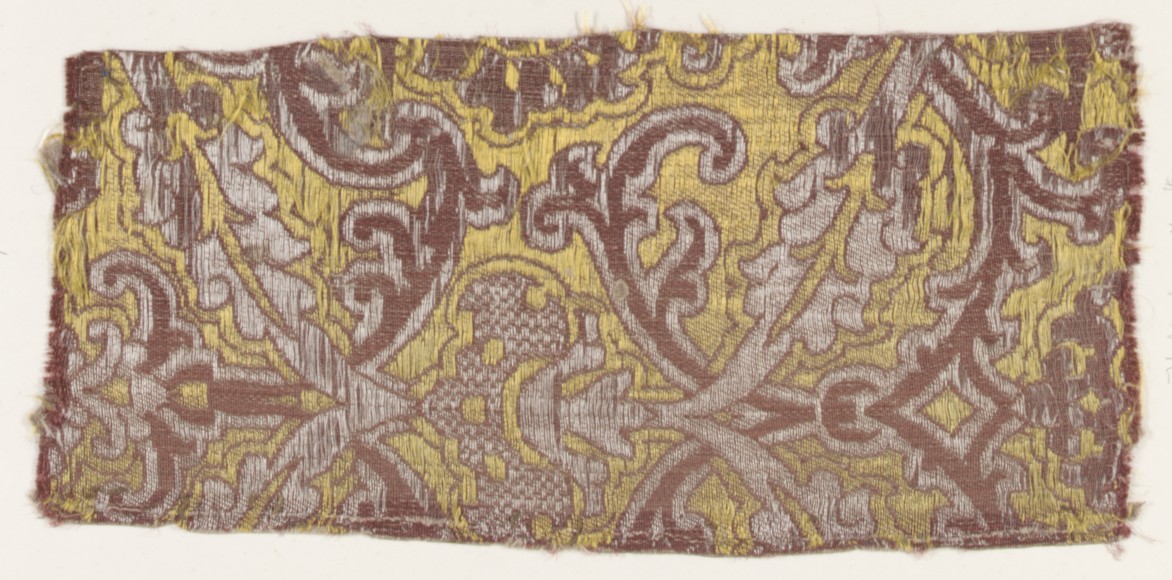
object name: fragment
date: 1601-1700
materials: metal thread, silk